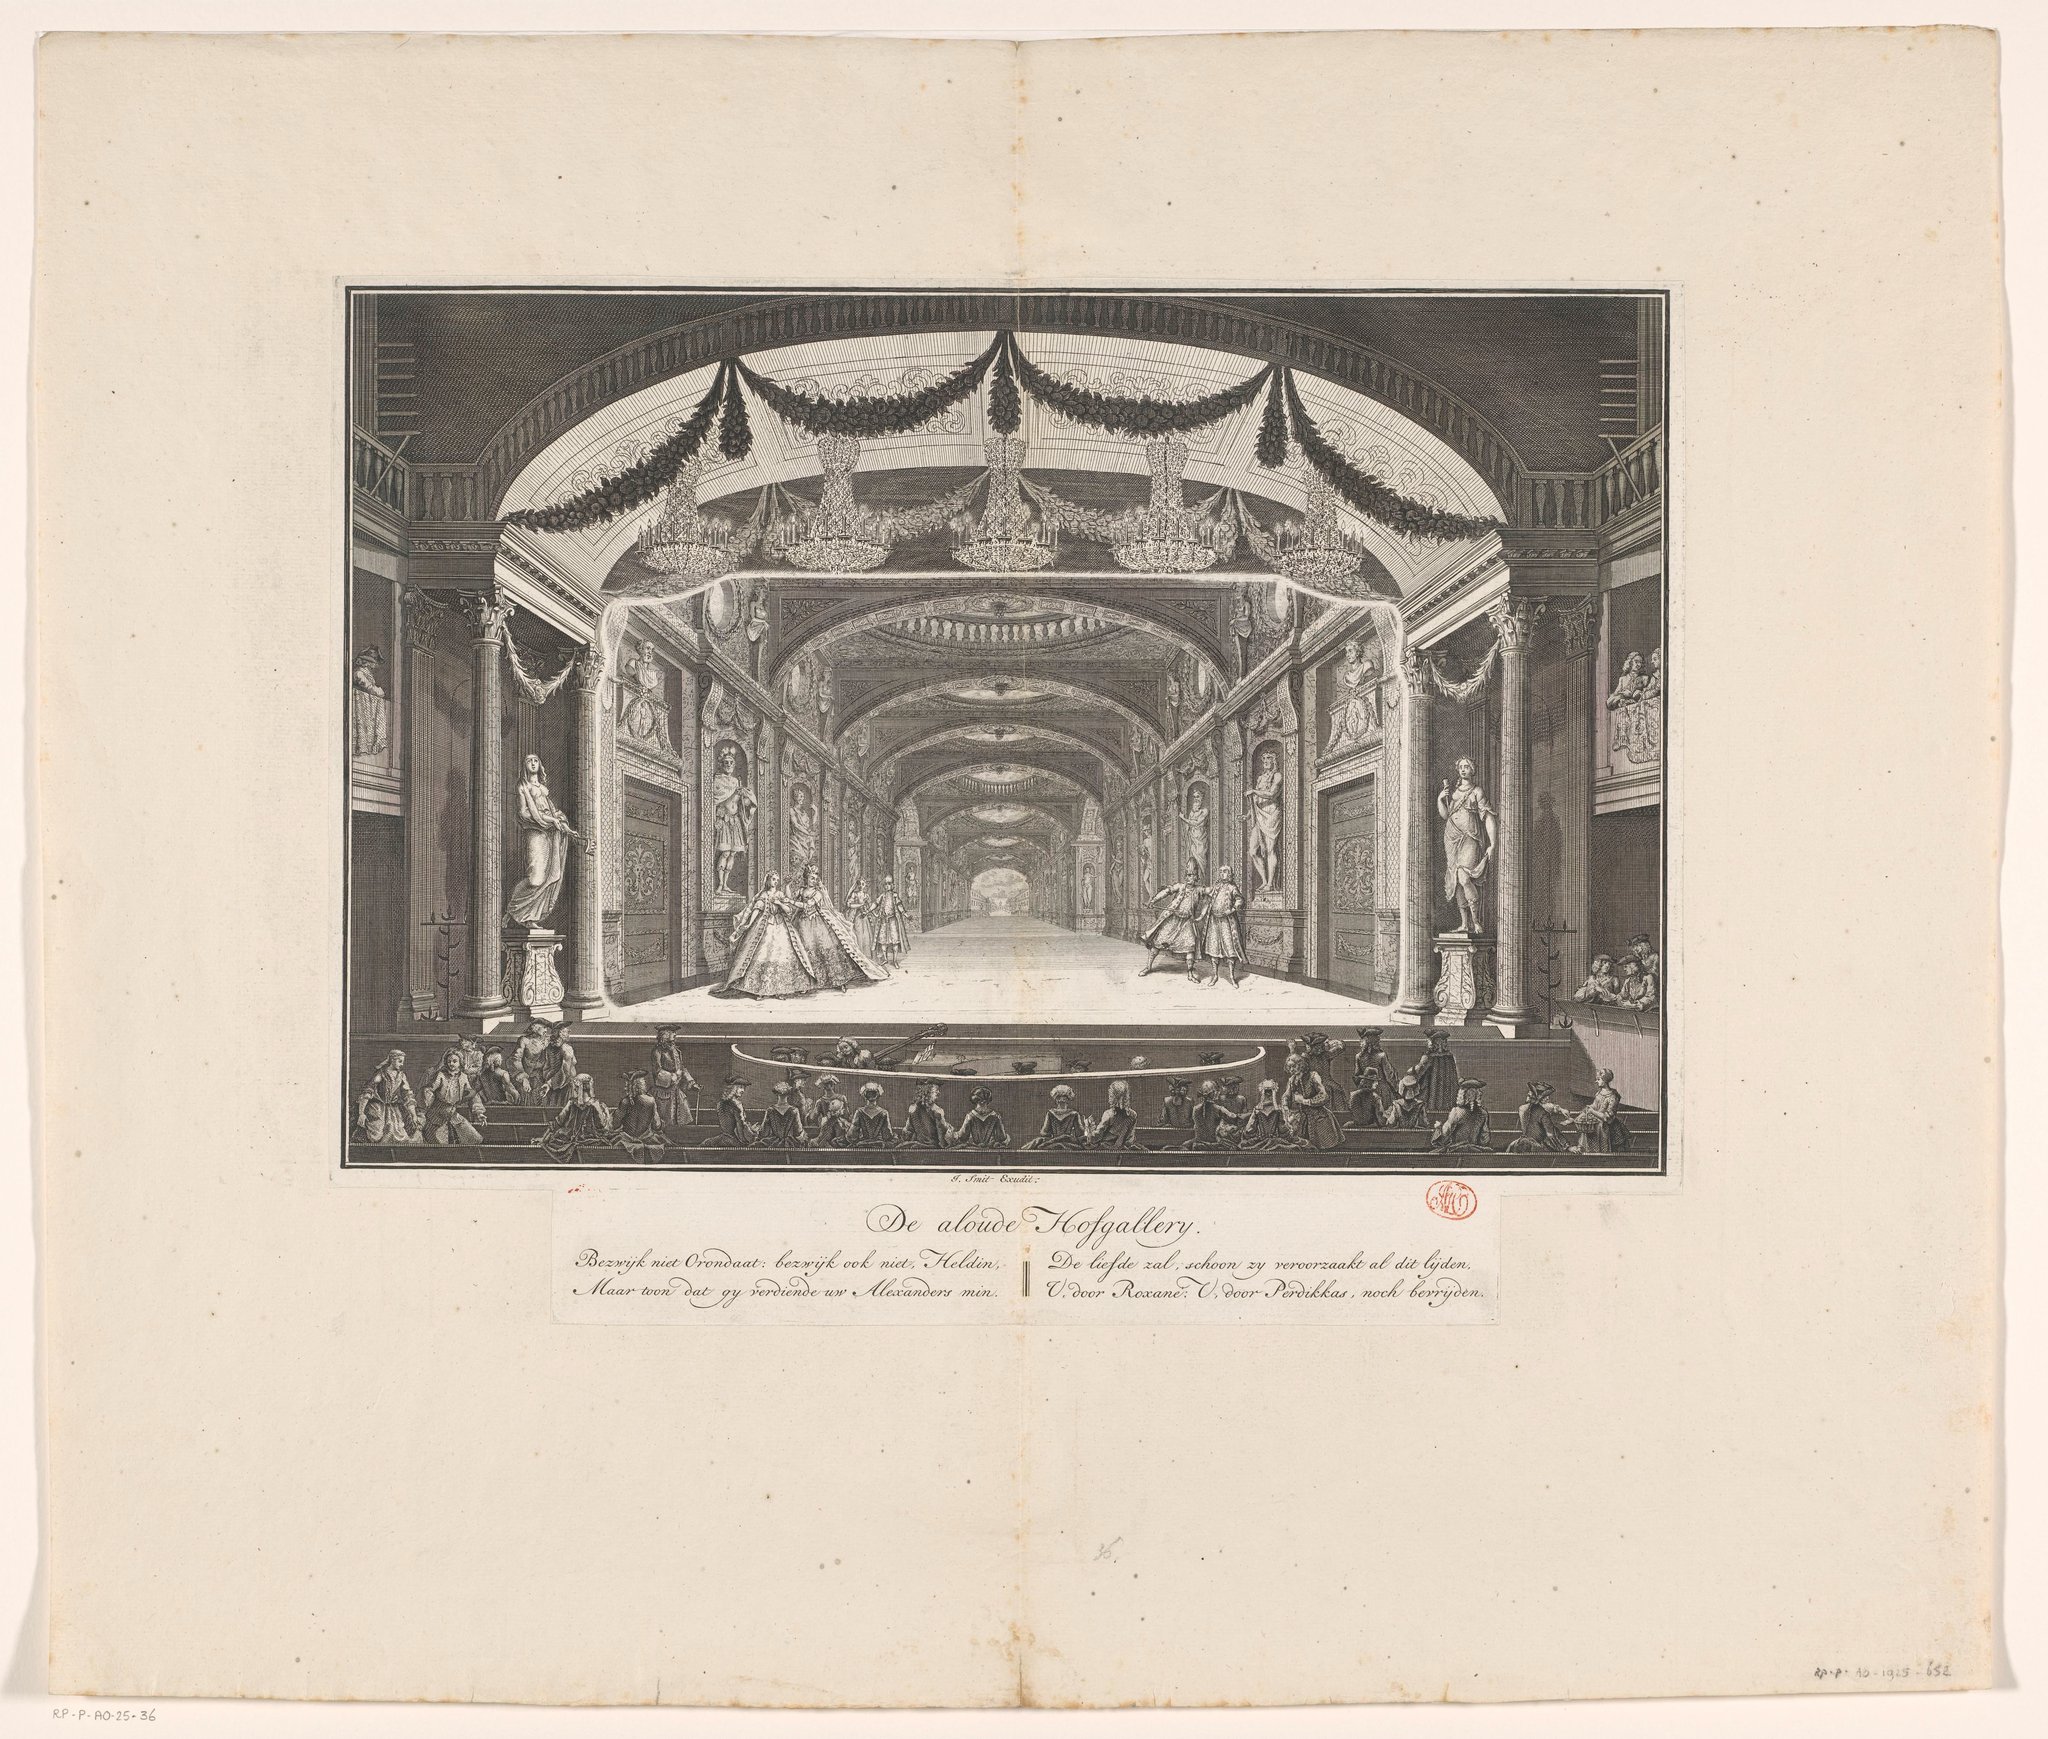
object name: print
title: De aloude Hofgallery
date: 1736-1738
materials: paper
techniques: engraving, etching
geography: amsterdam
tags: theatre, theatrical performance, stage design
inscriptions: collector's mark: Lugt 195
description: Scène uit het toneelstuk "Het huwelyk van Orondates en Statira. Treurspel." door Jean Magnon (vertaald door D. Lingelbach), Amsterdam 1715. Deze platen zijn in verschillende groepen in verschillende periodes vervaardigd tussen 1738-1760 en uitgegeven in verschillende series ca. 1760 (met dit passe-partout) en ca. 1770-1772 (met een ander passe-partout). De platen zijn door Muller ingedeeld bij de platen van de brand van de Amsterdamse Schouwburg in 1772.